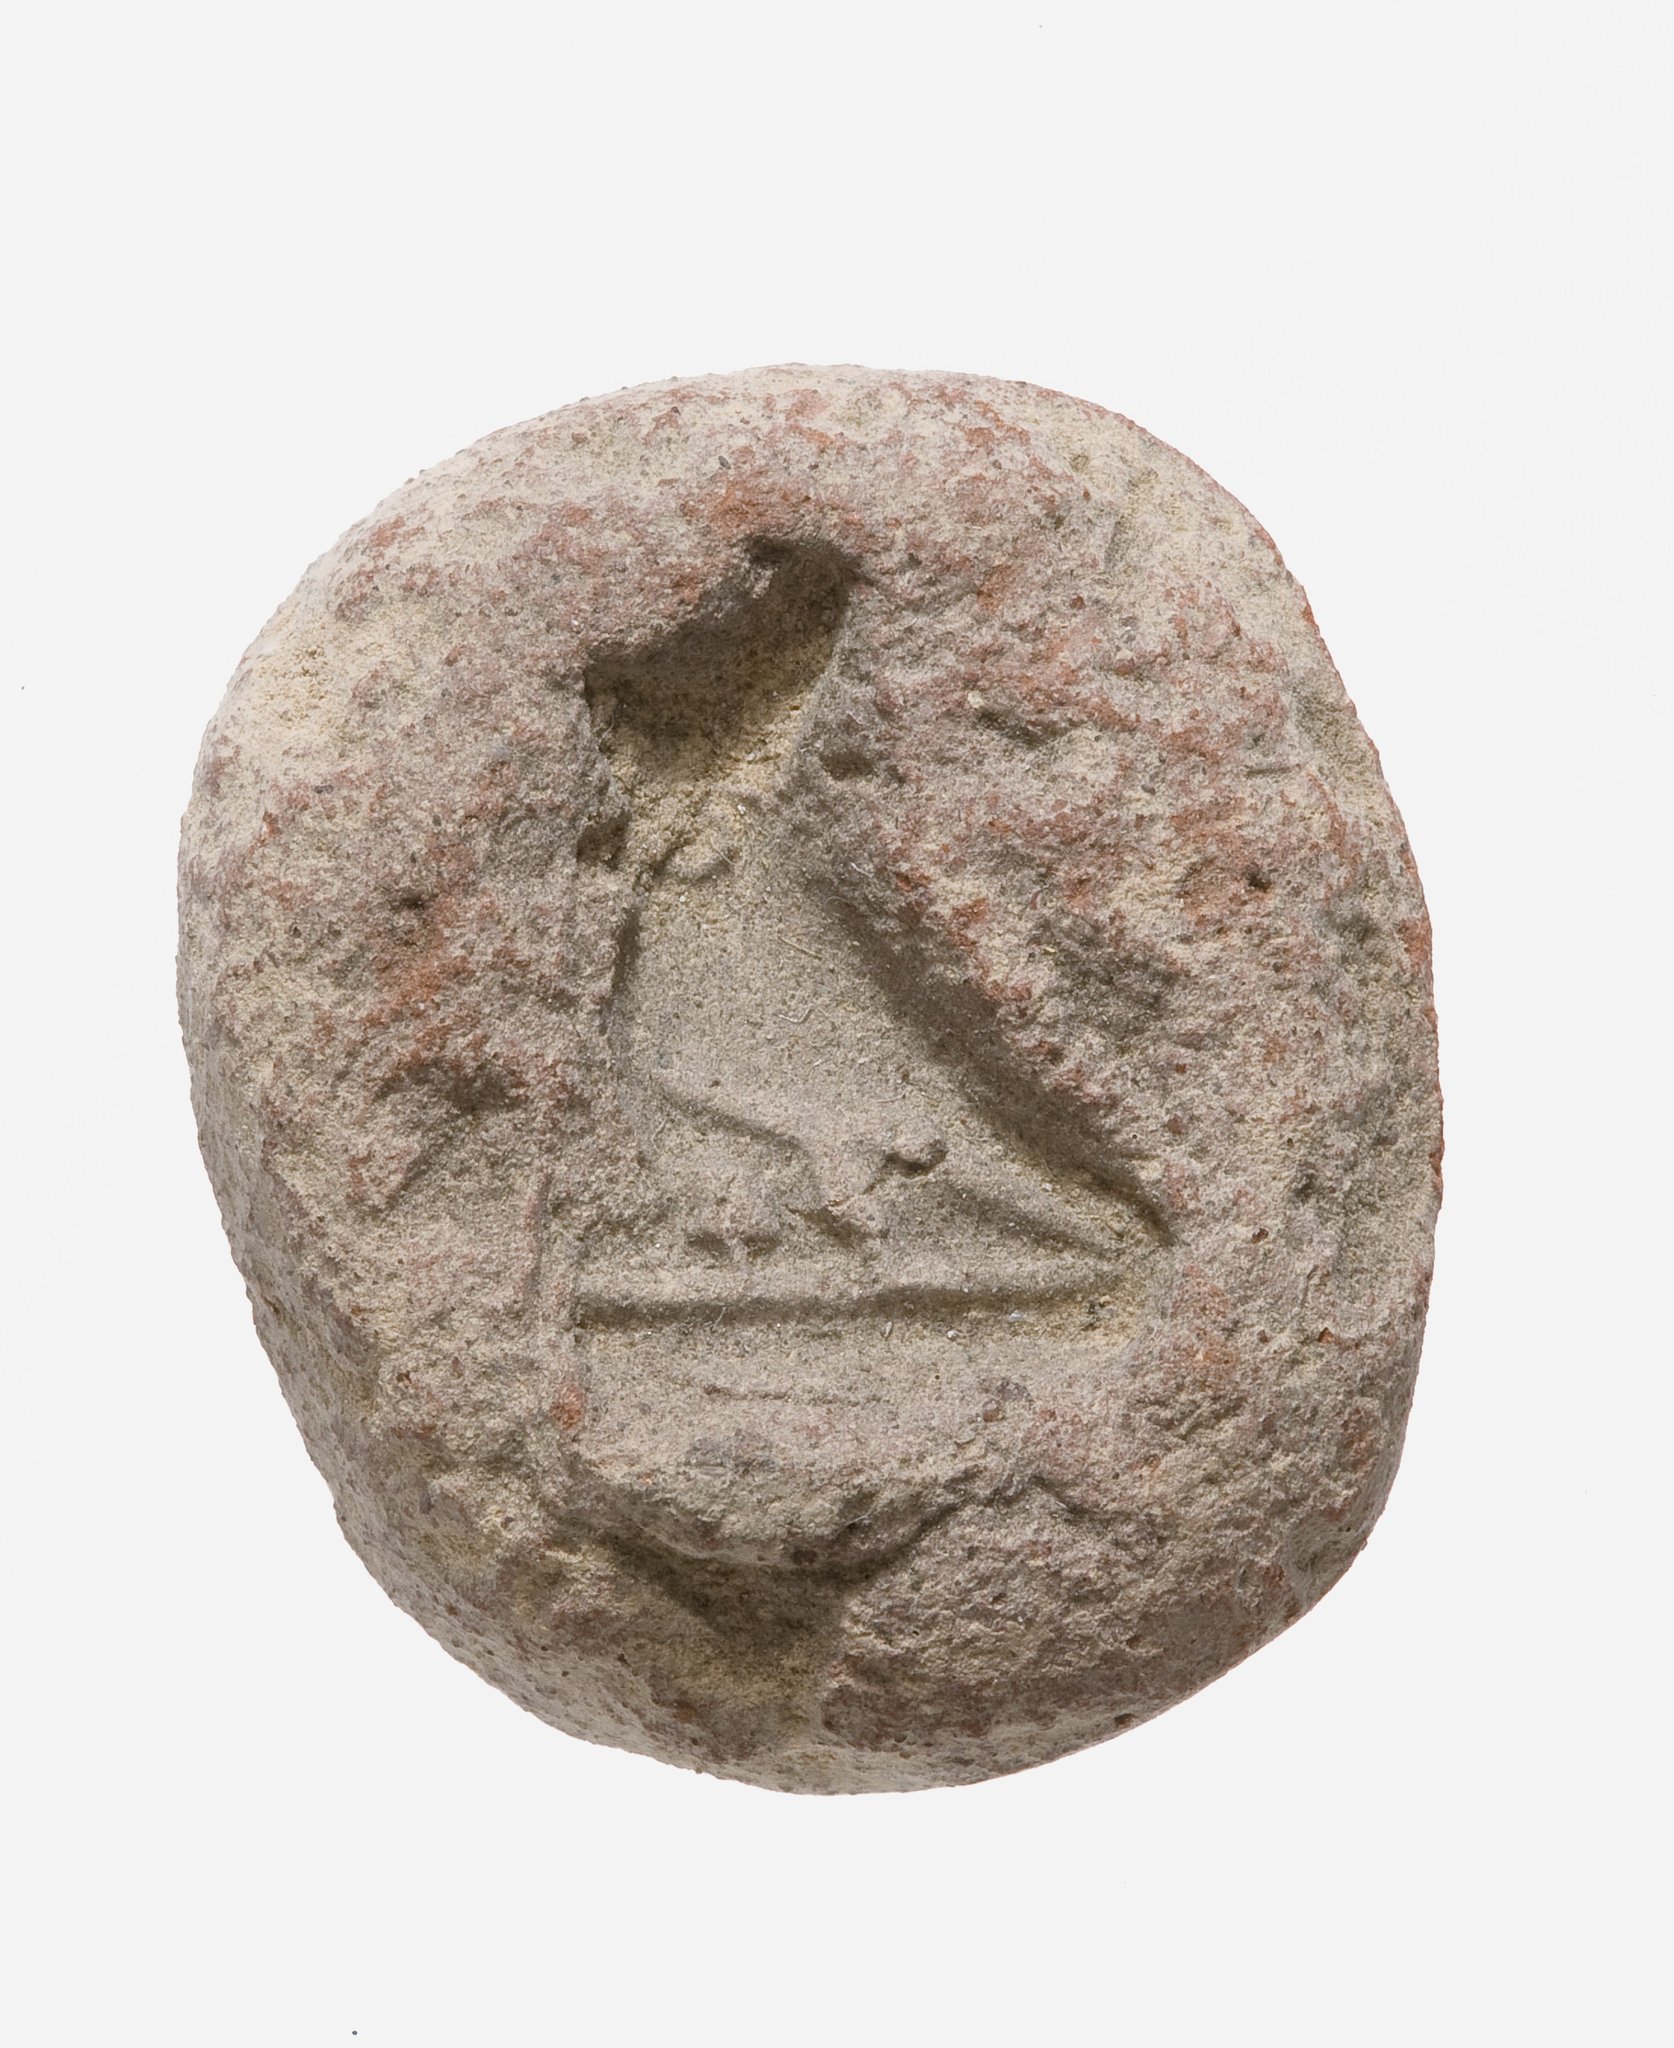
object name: mold, amulet, horus, falcon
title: Mold for a Horus Amulet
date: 1390-1352 BCE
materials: pottery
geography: egypt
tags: horus